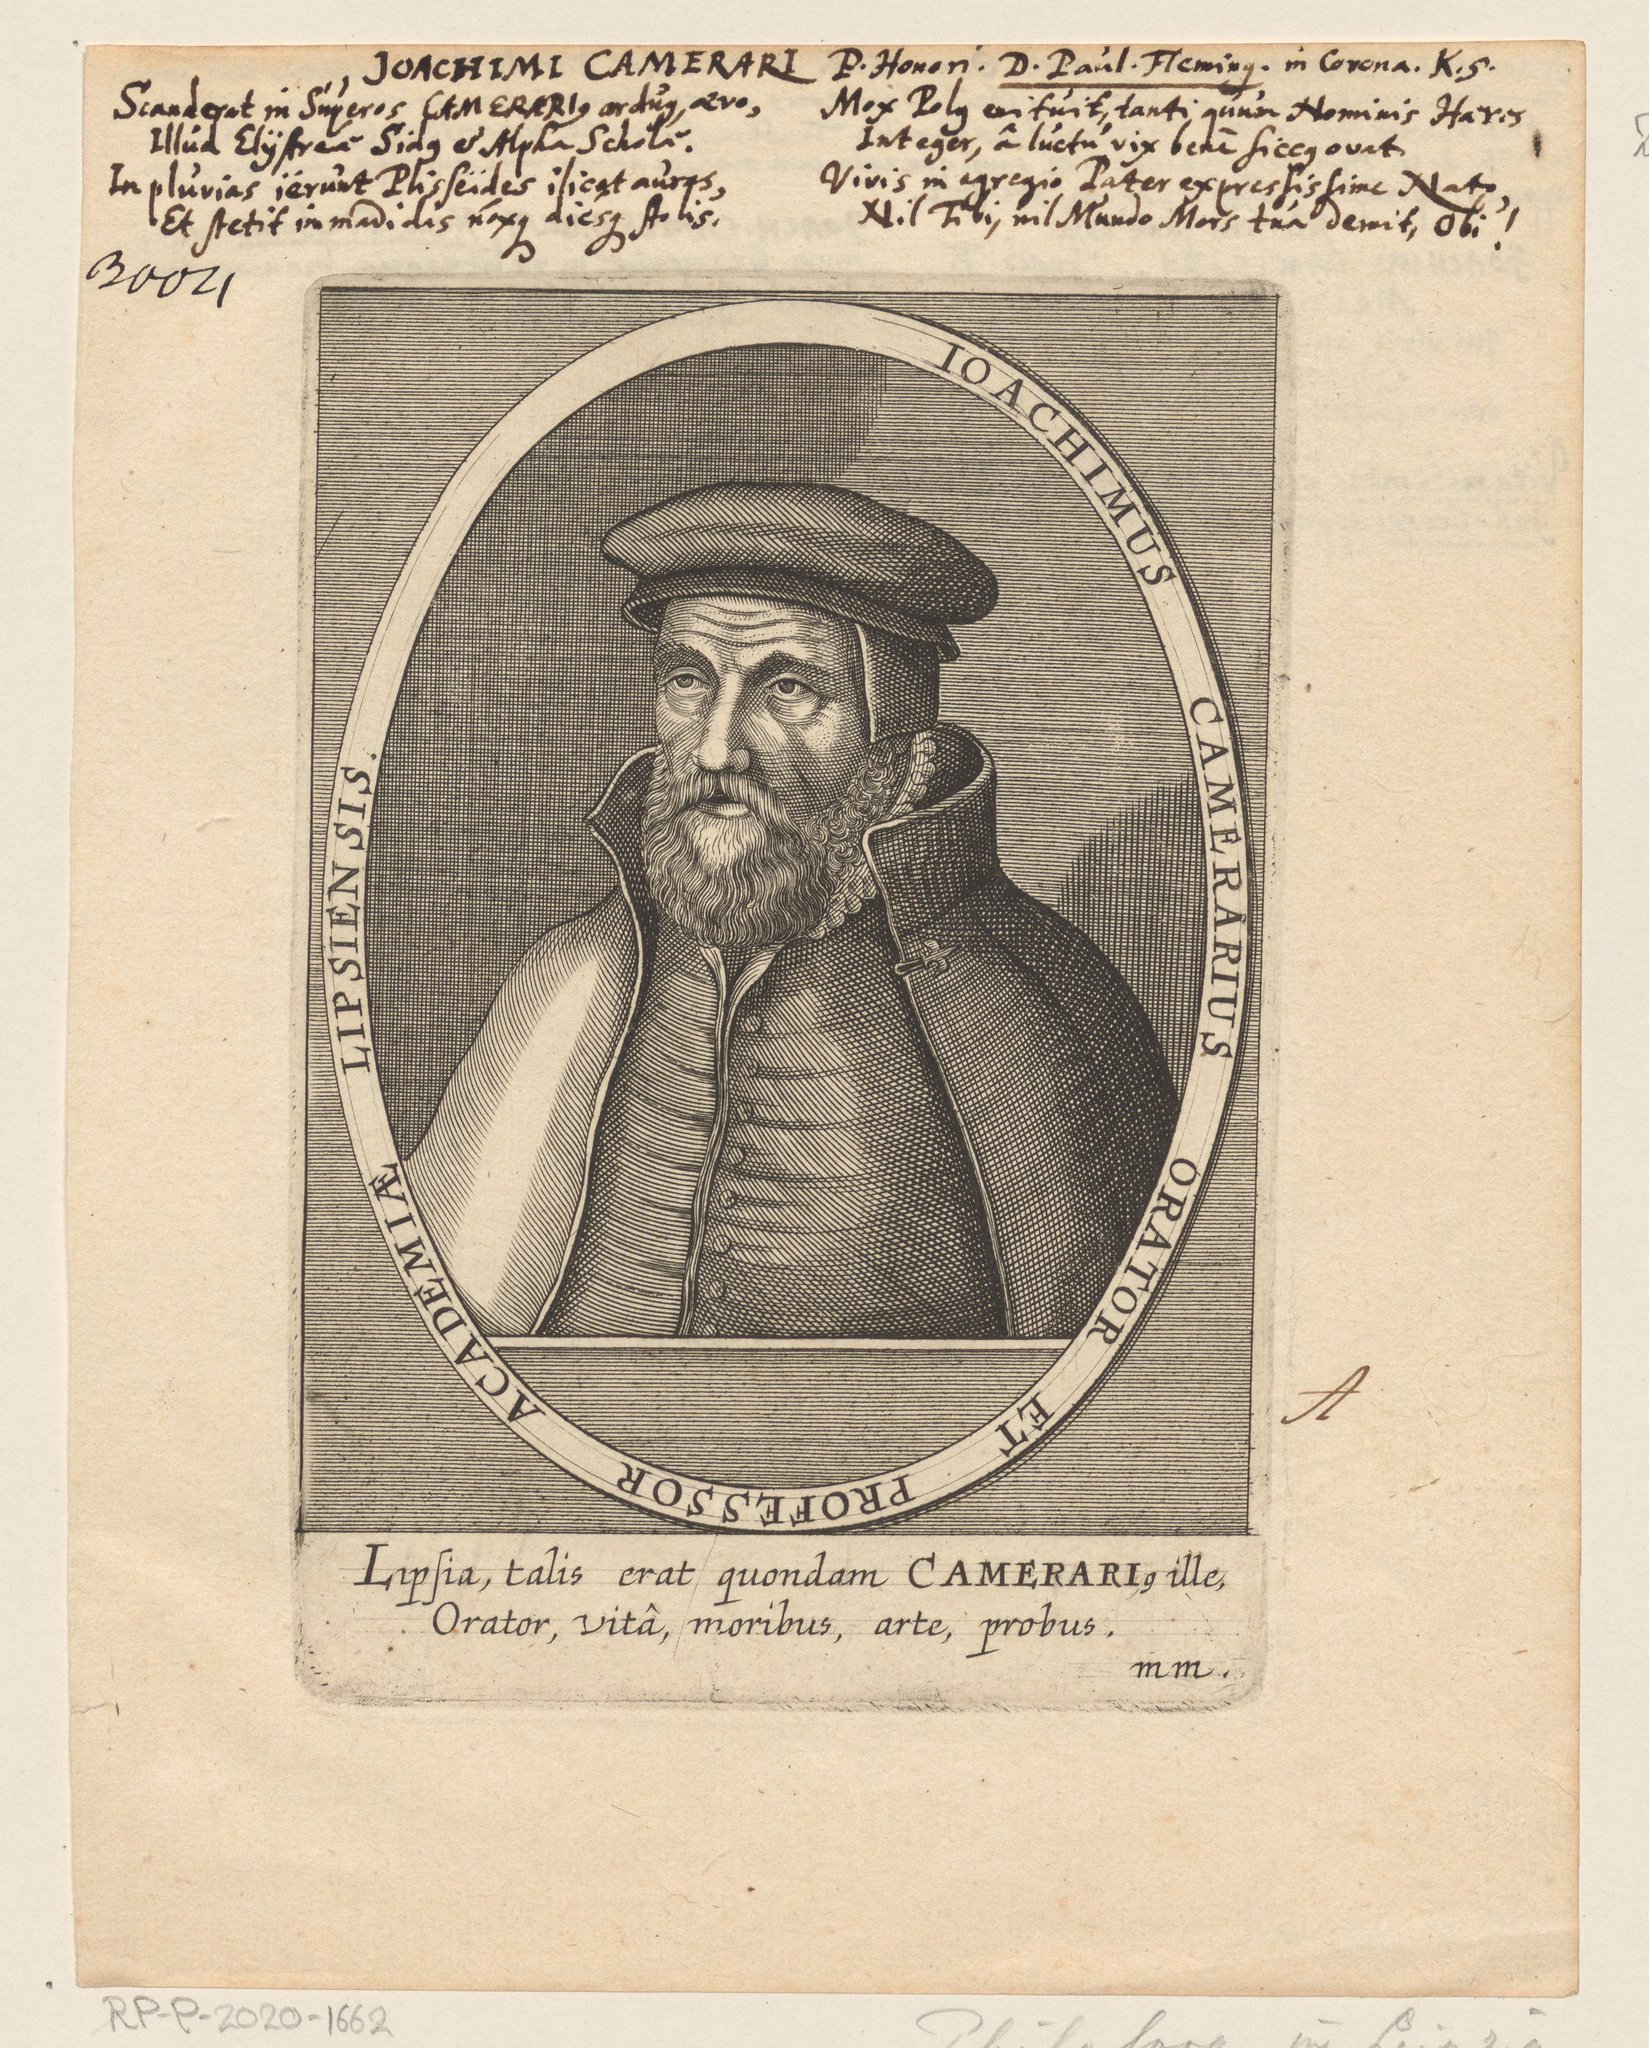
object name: print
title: Portret van Joachim Camerarius I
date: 1650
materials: ink, paper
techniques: engraving, pen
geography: frankfurt am main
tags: joachim camerarius (i), historical persons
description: Prent waarschijnlijk uit: Boissard, Jean Jacques. Bibliotheca chalcographica. 8 dln. Frankfurt am Main: Johannes Ammon, 1650, dl. 7.Ook gebruikt in latere edities. Eerdere staat van prent verschenen in: Boissard, Jean Jacques. Icones quinquaginta virorum illustrium doctrina & eruditione praestantium ad vivum effictae. 4 dln. Frankfurt am Main: s.n., 1597-1599. Mogelijk ook gebruikt in latere edities.